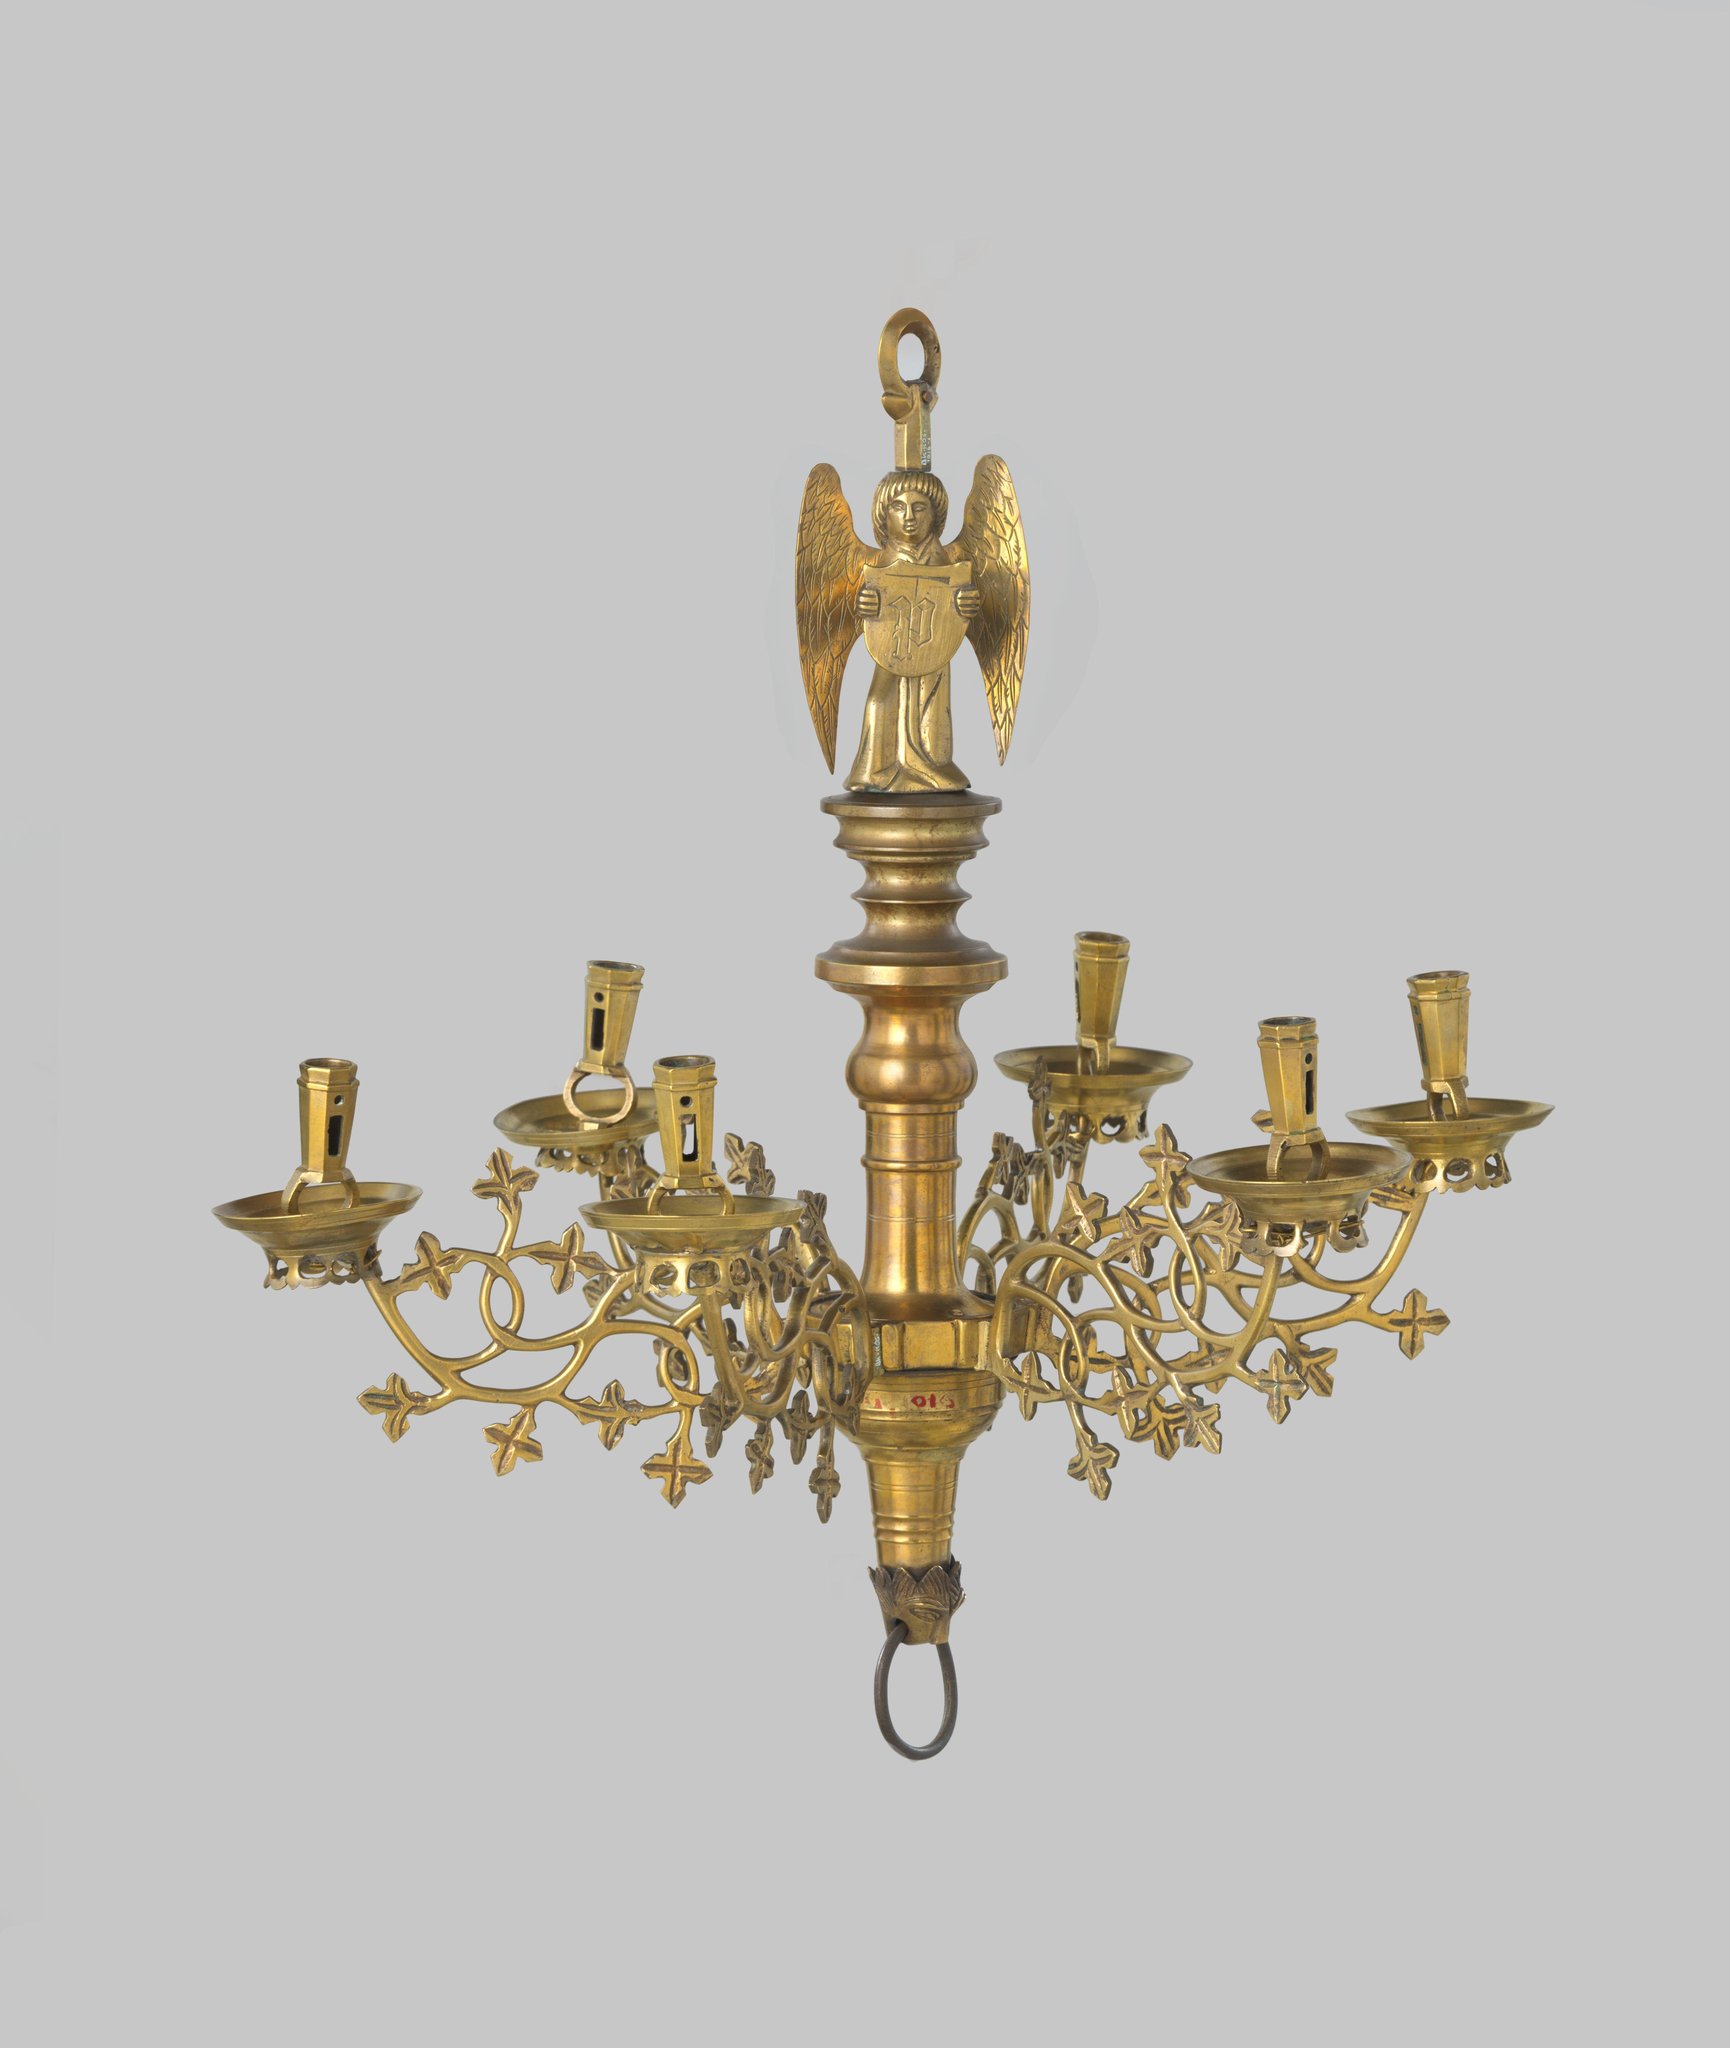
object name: chandelier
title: Arm met kaarsenhouder van kaarsenkroon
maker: Anonymous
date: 1825-1875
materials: brass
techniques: casting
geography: western europe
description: Kaarsenarm behorende bij een messing kaarsenkroon. De S-vormige arm is versierd met negen wingerdbladeren wingerdbladeren, ten dele aan verstrengelde ranken, en eindigt in de platte verdikking met een schroefgat. De ronde vetvanger is voorzien van ajour bewerkte gekartelde versieringen aan de onderzijde. Deze is bevestigd met een achtvlakkige voor en achter geperforeerde kaarsenhouder op verticale ringvormige voet, die op de armen zijn geschroefd. Dit is de tweede arm, genummerd met 2 driehoeken.